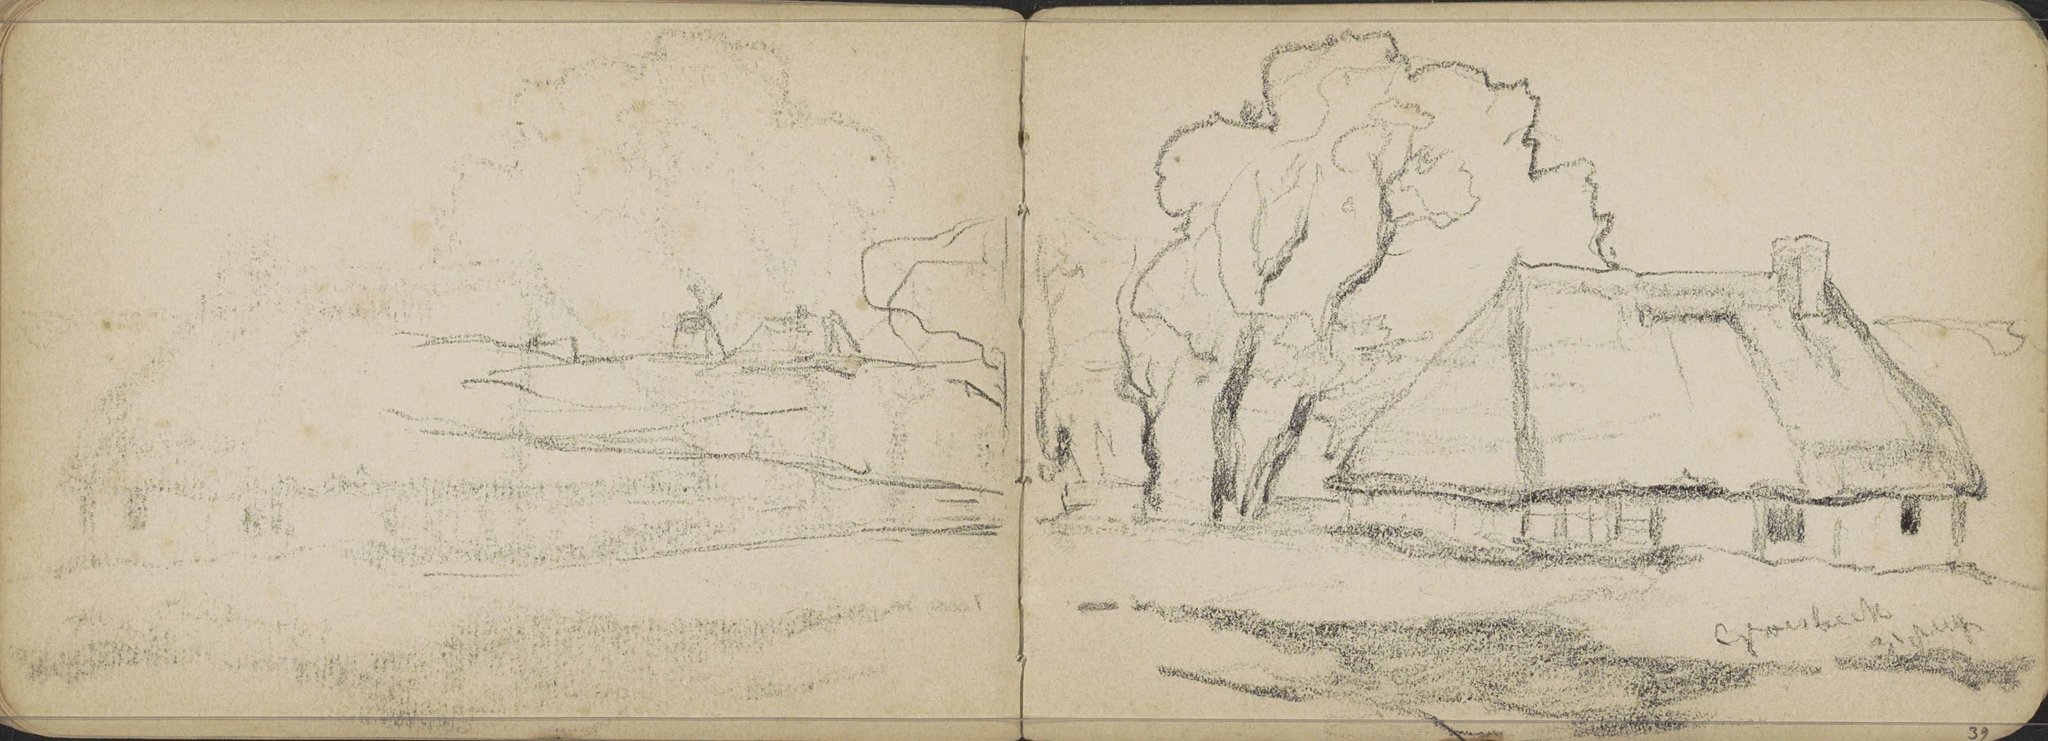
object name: sketchbook leaf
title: Boerderij te Groesbeek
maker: willem cornelis rip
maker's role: draughtsman, painter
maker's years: 1856-1922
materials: chalk, paper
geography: groesbeek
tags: farm or solitary house in landscape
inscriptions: date and inscription: ‘Groesbeek/ 31 Aug.’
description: Blad 38 verso en 39 recto uit een schetsboek met 44 bladen.